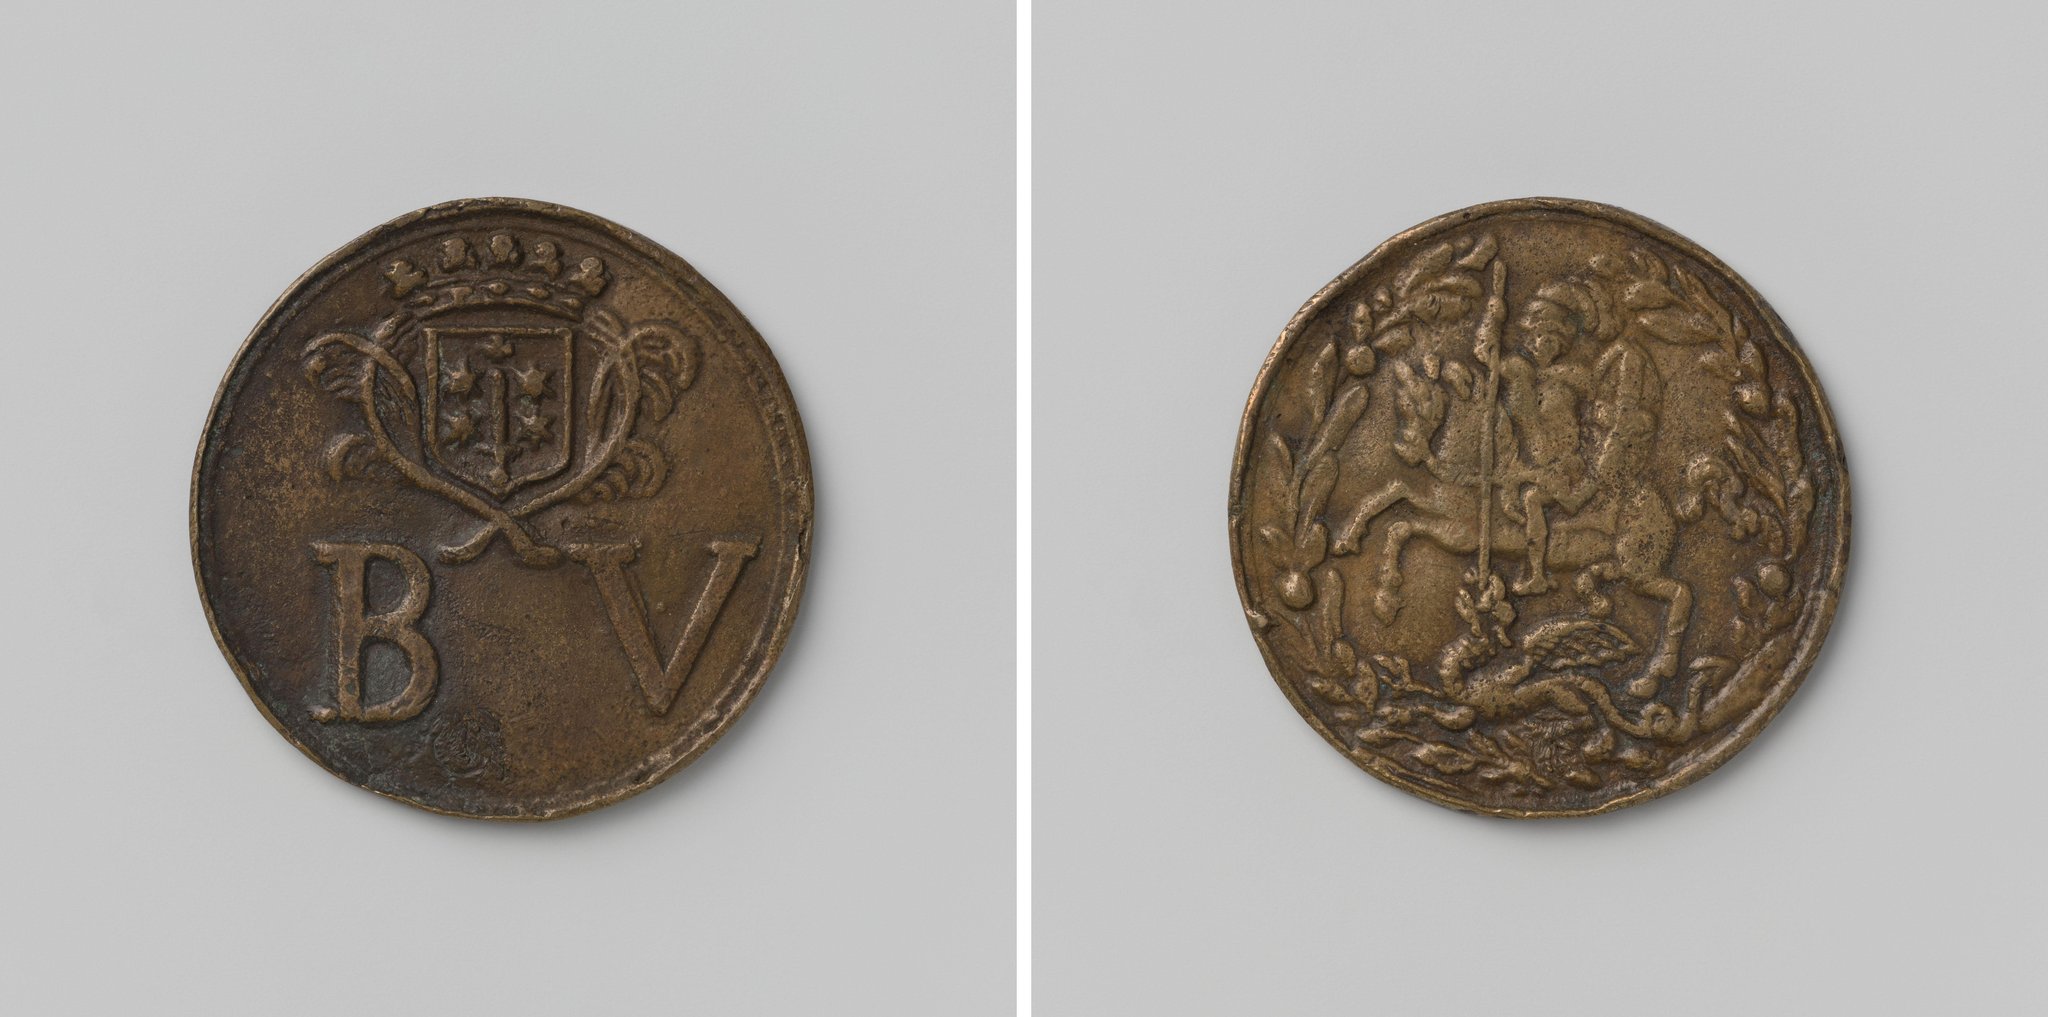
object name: marksman medal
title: Schutterij van Haarlem, schutterspenning van het Blauwe Vaandel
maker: Anonymous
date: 1650-1750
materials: brass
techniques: casting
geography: haarlem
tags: haarlem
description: Messing penning. Voorzijde: gekroond wapenschild op twee gekruiste palmtakken boven letters B en V. Keerzijde: gehelmde St. Joris te paard met schild in linkerhand doodt met speer ter aarde liggende draak